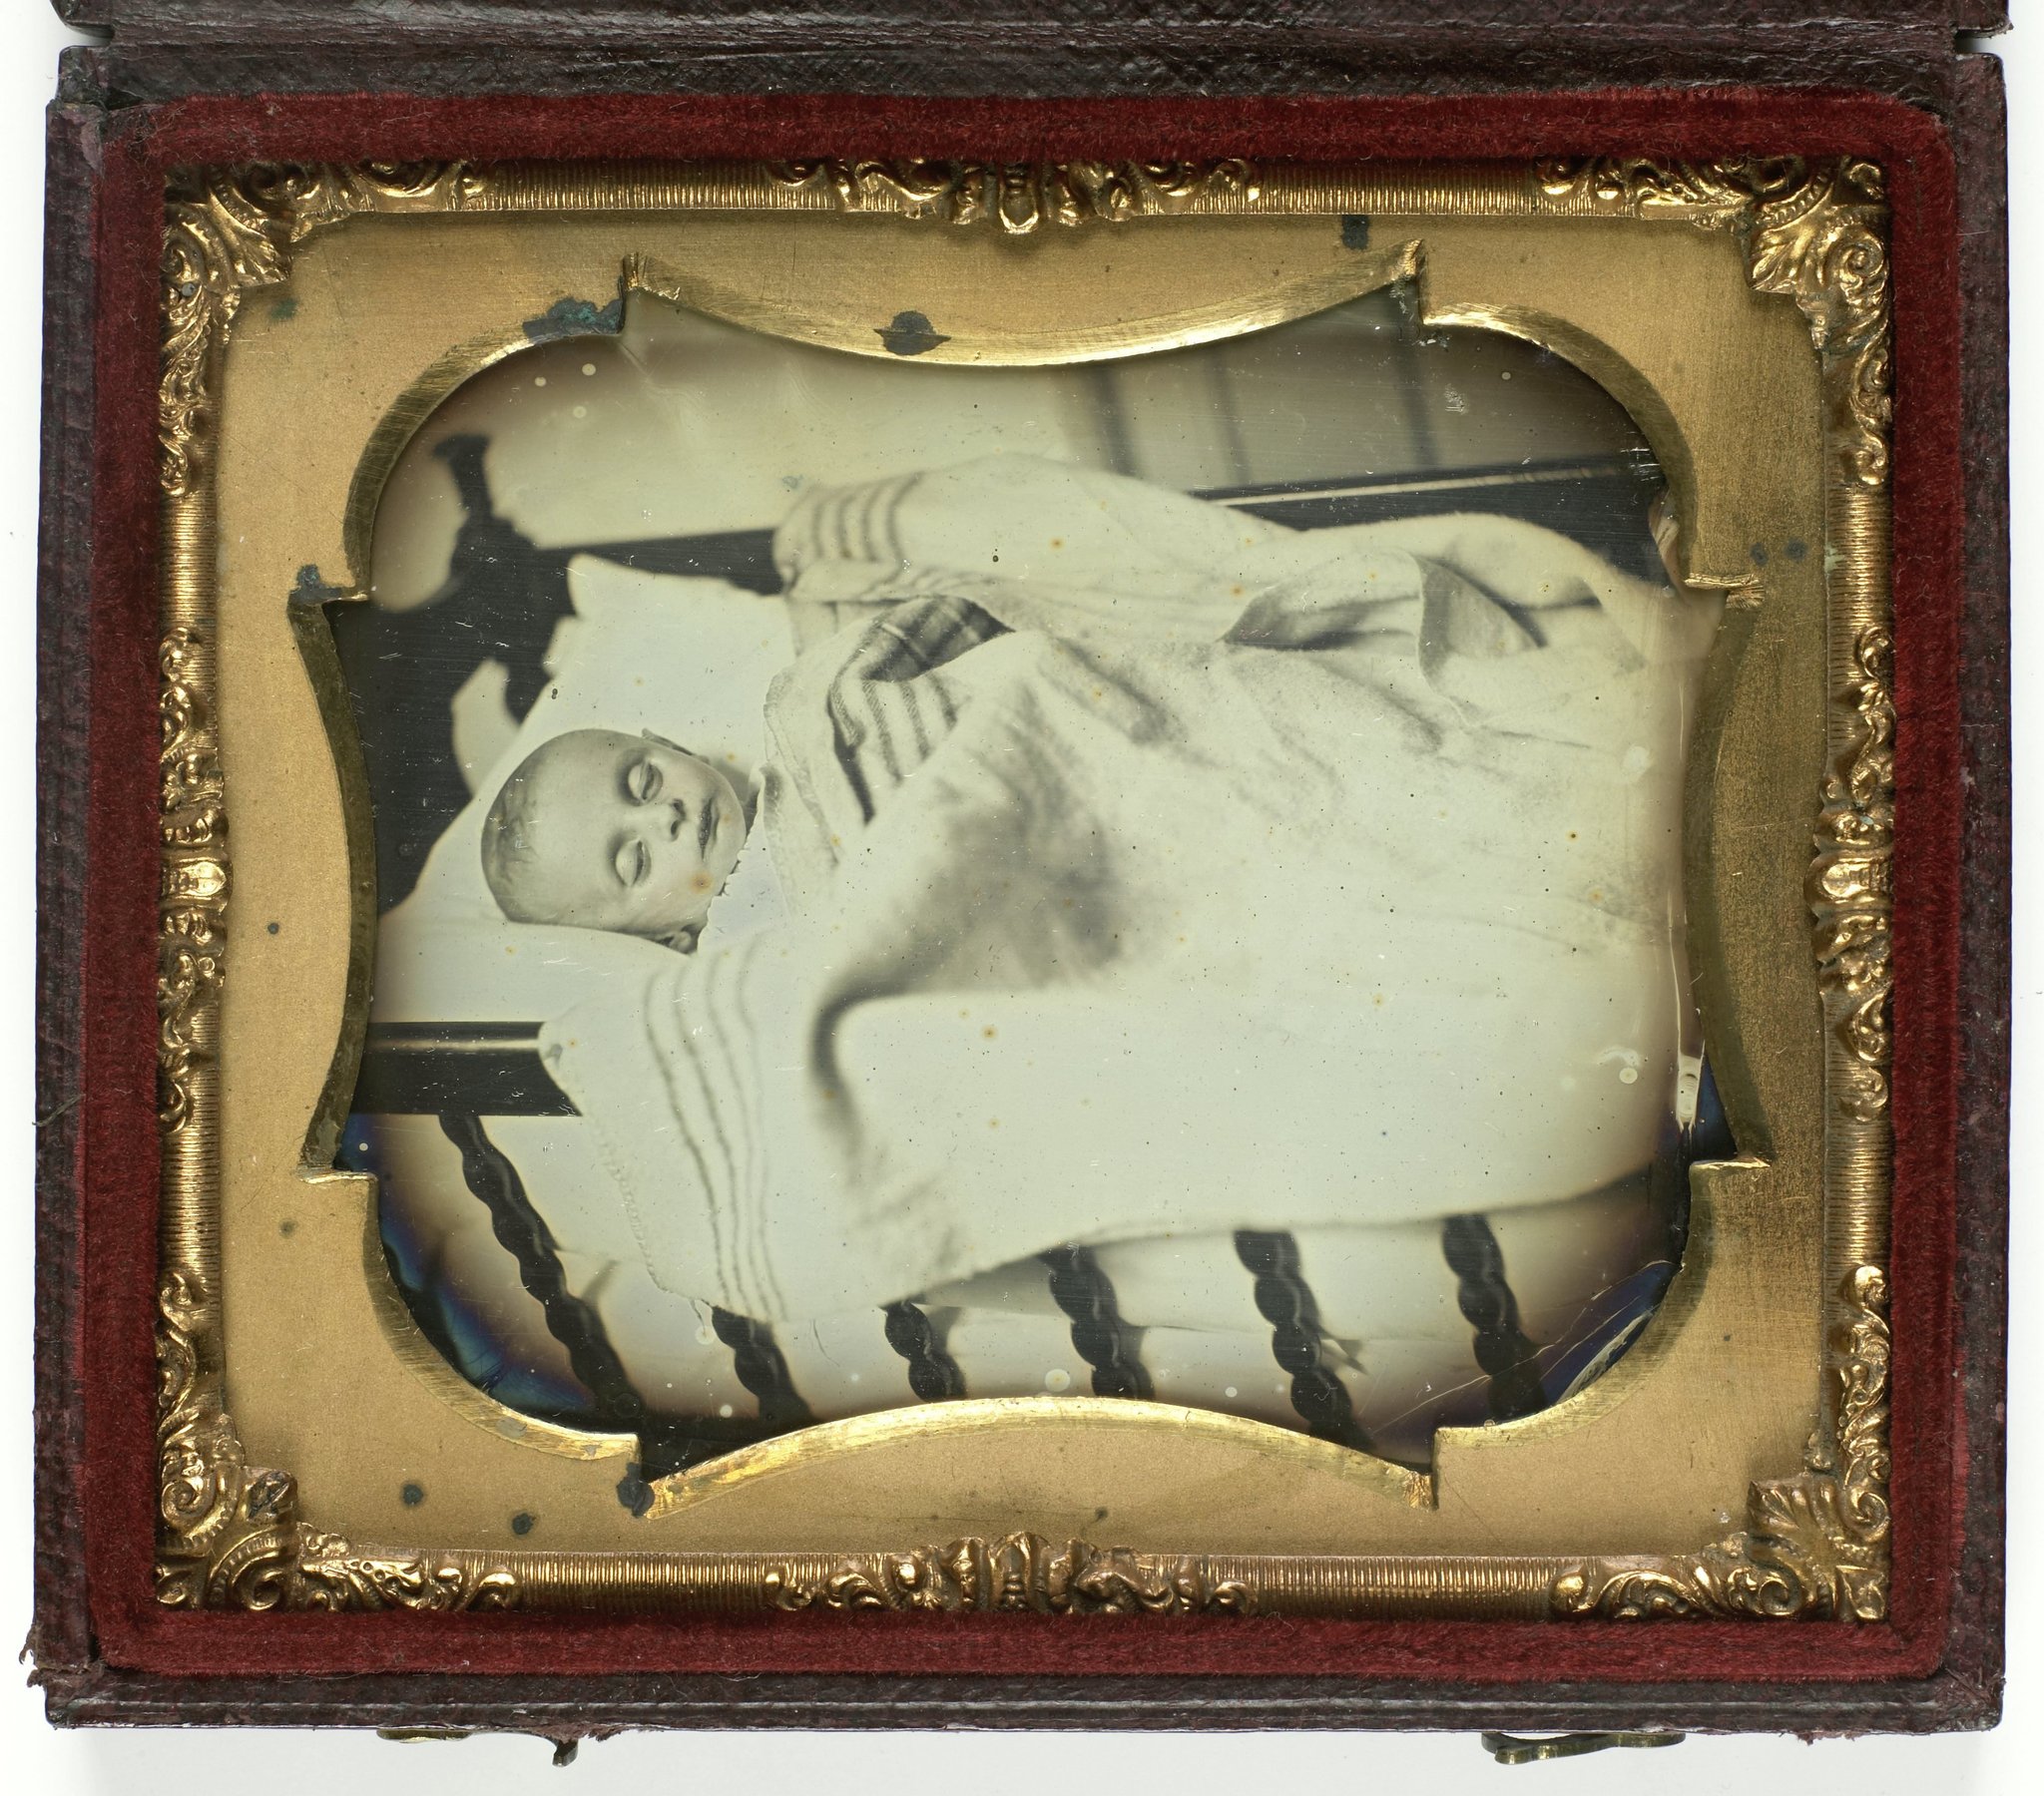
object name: photograph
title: Post-mortemportret van een baby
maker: Anonymous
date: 1840-1860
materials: copper, glass, leather, velvet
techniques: daguerreotype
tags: historical persons, the corpse, infant, baby